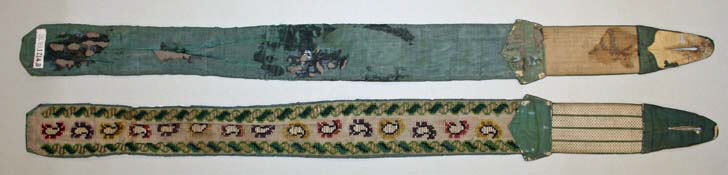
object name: suspender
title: Suspenders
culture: european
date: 1801-1900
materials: silk